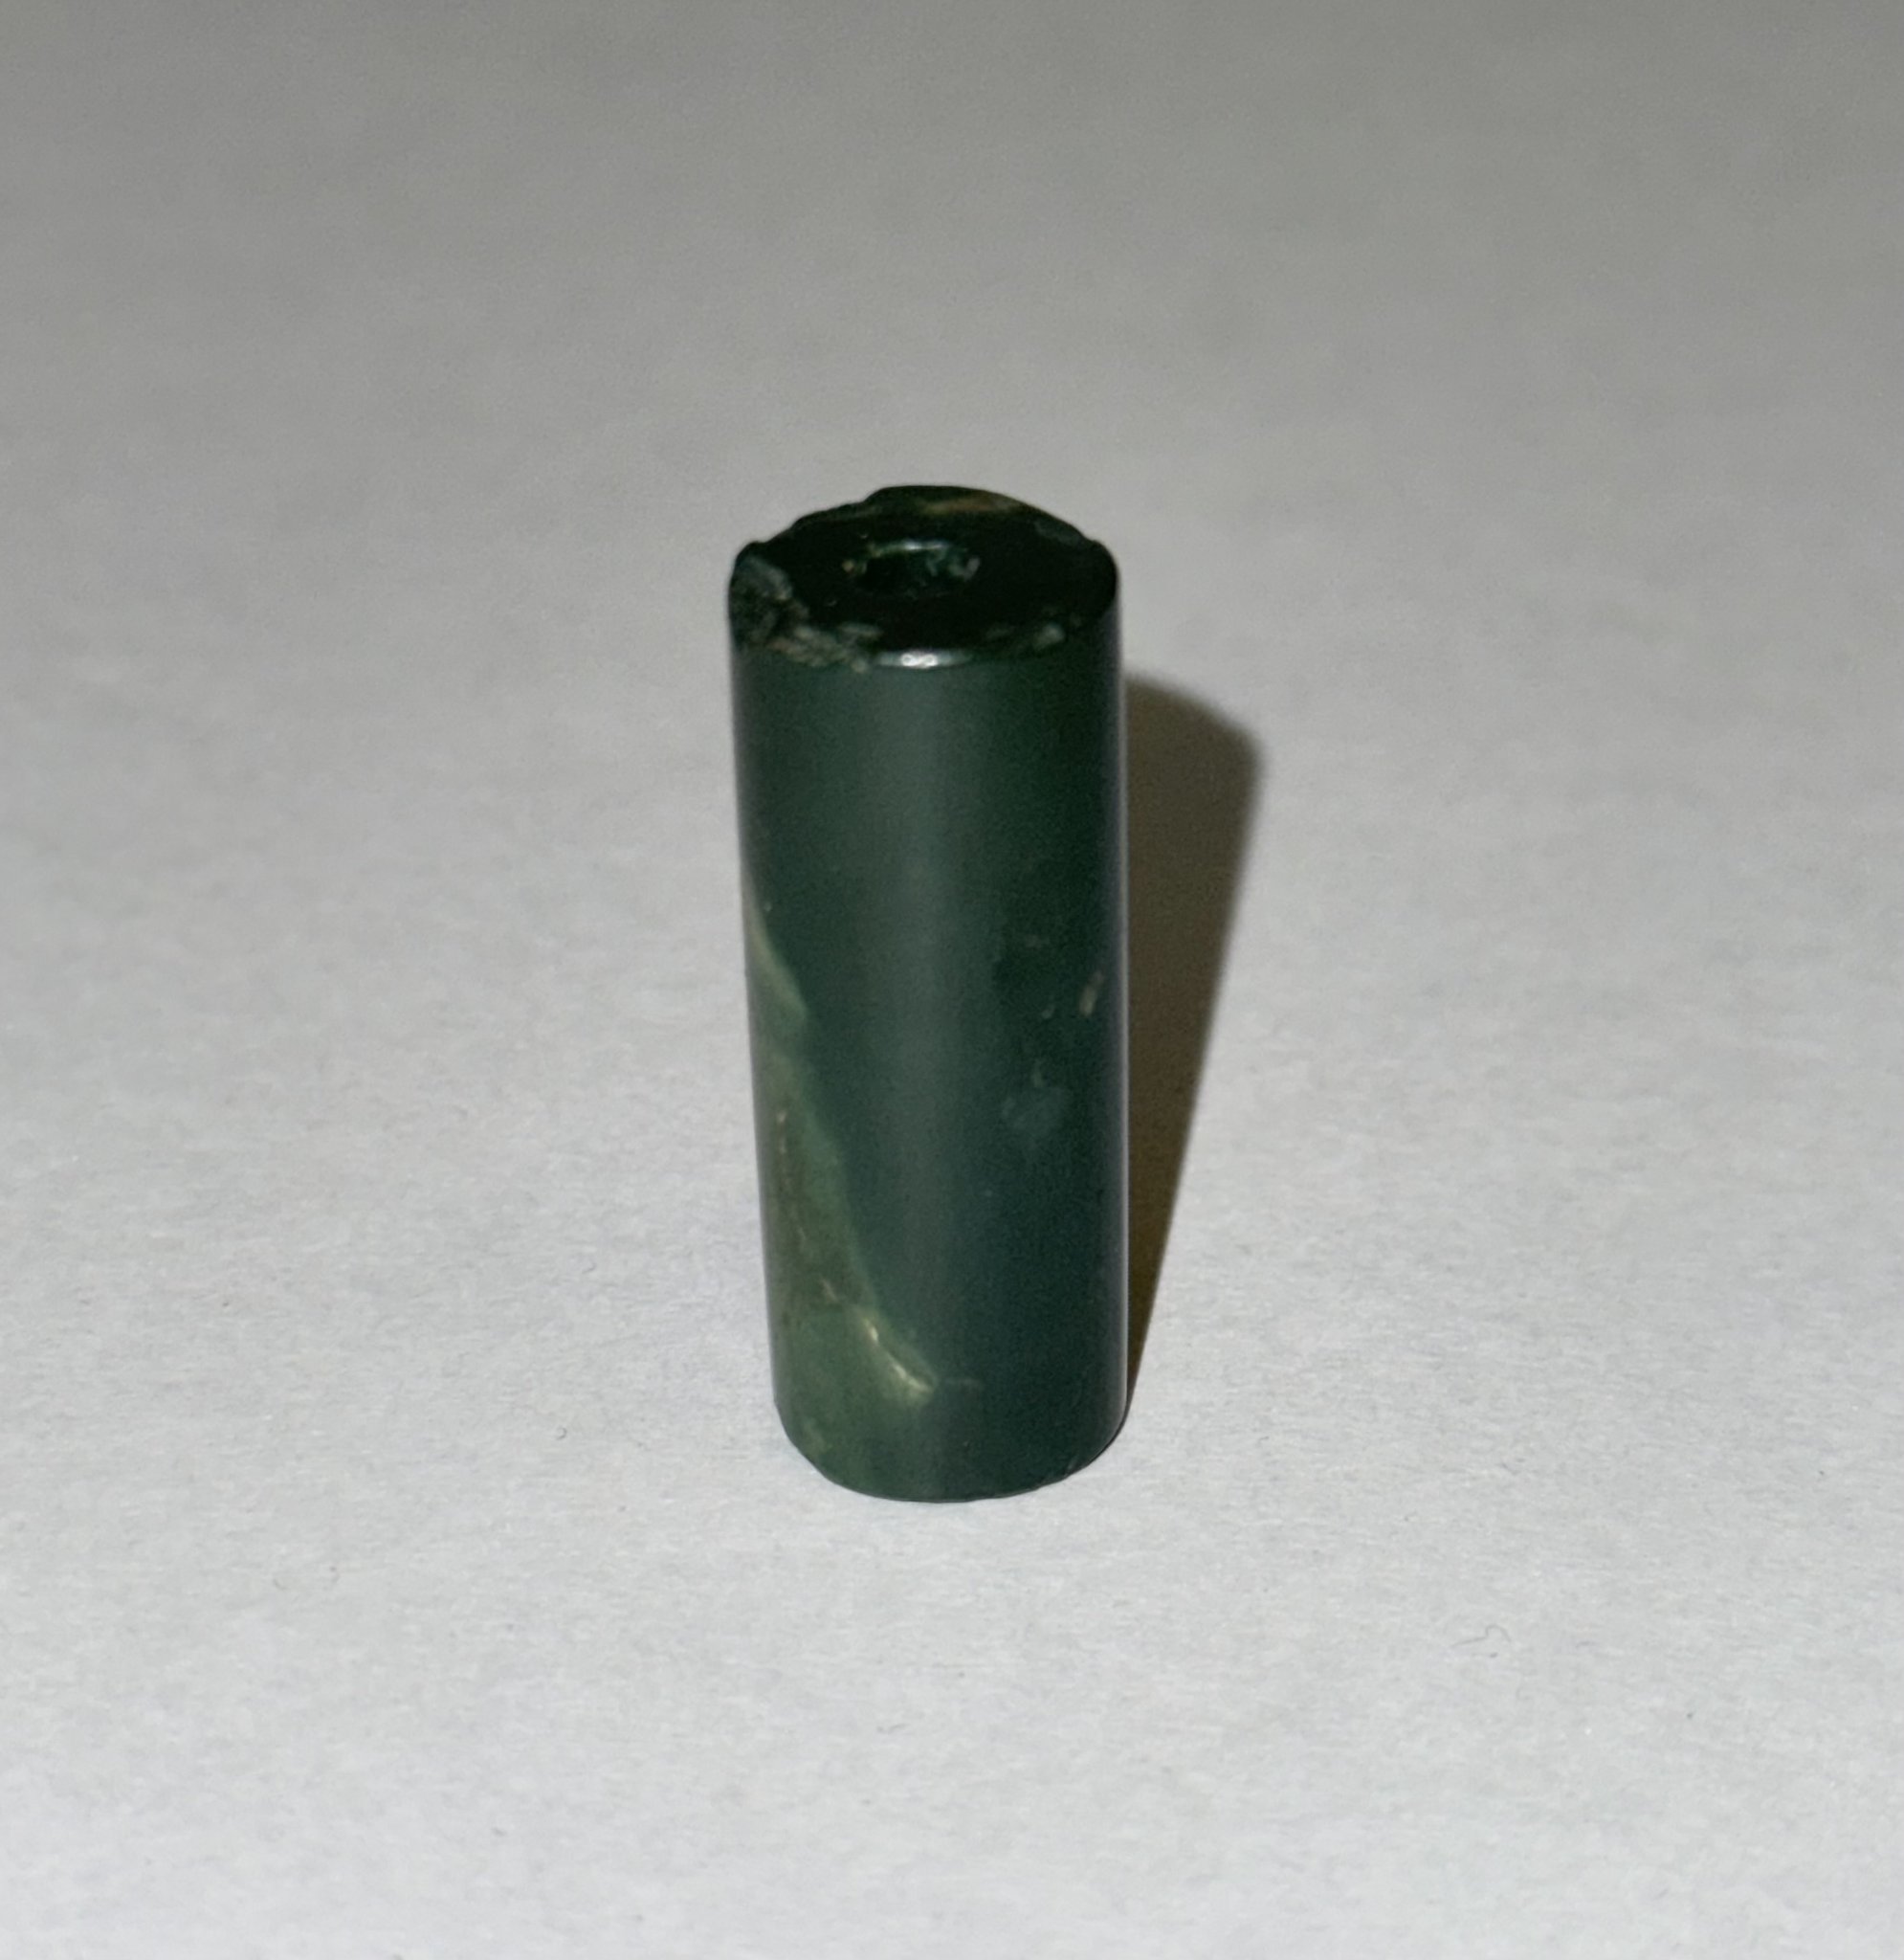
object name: cylinder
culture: japanese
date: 601-700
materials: jasper